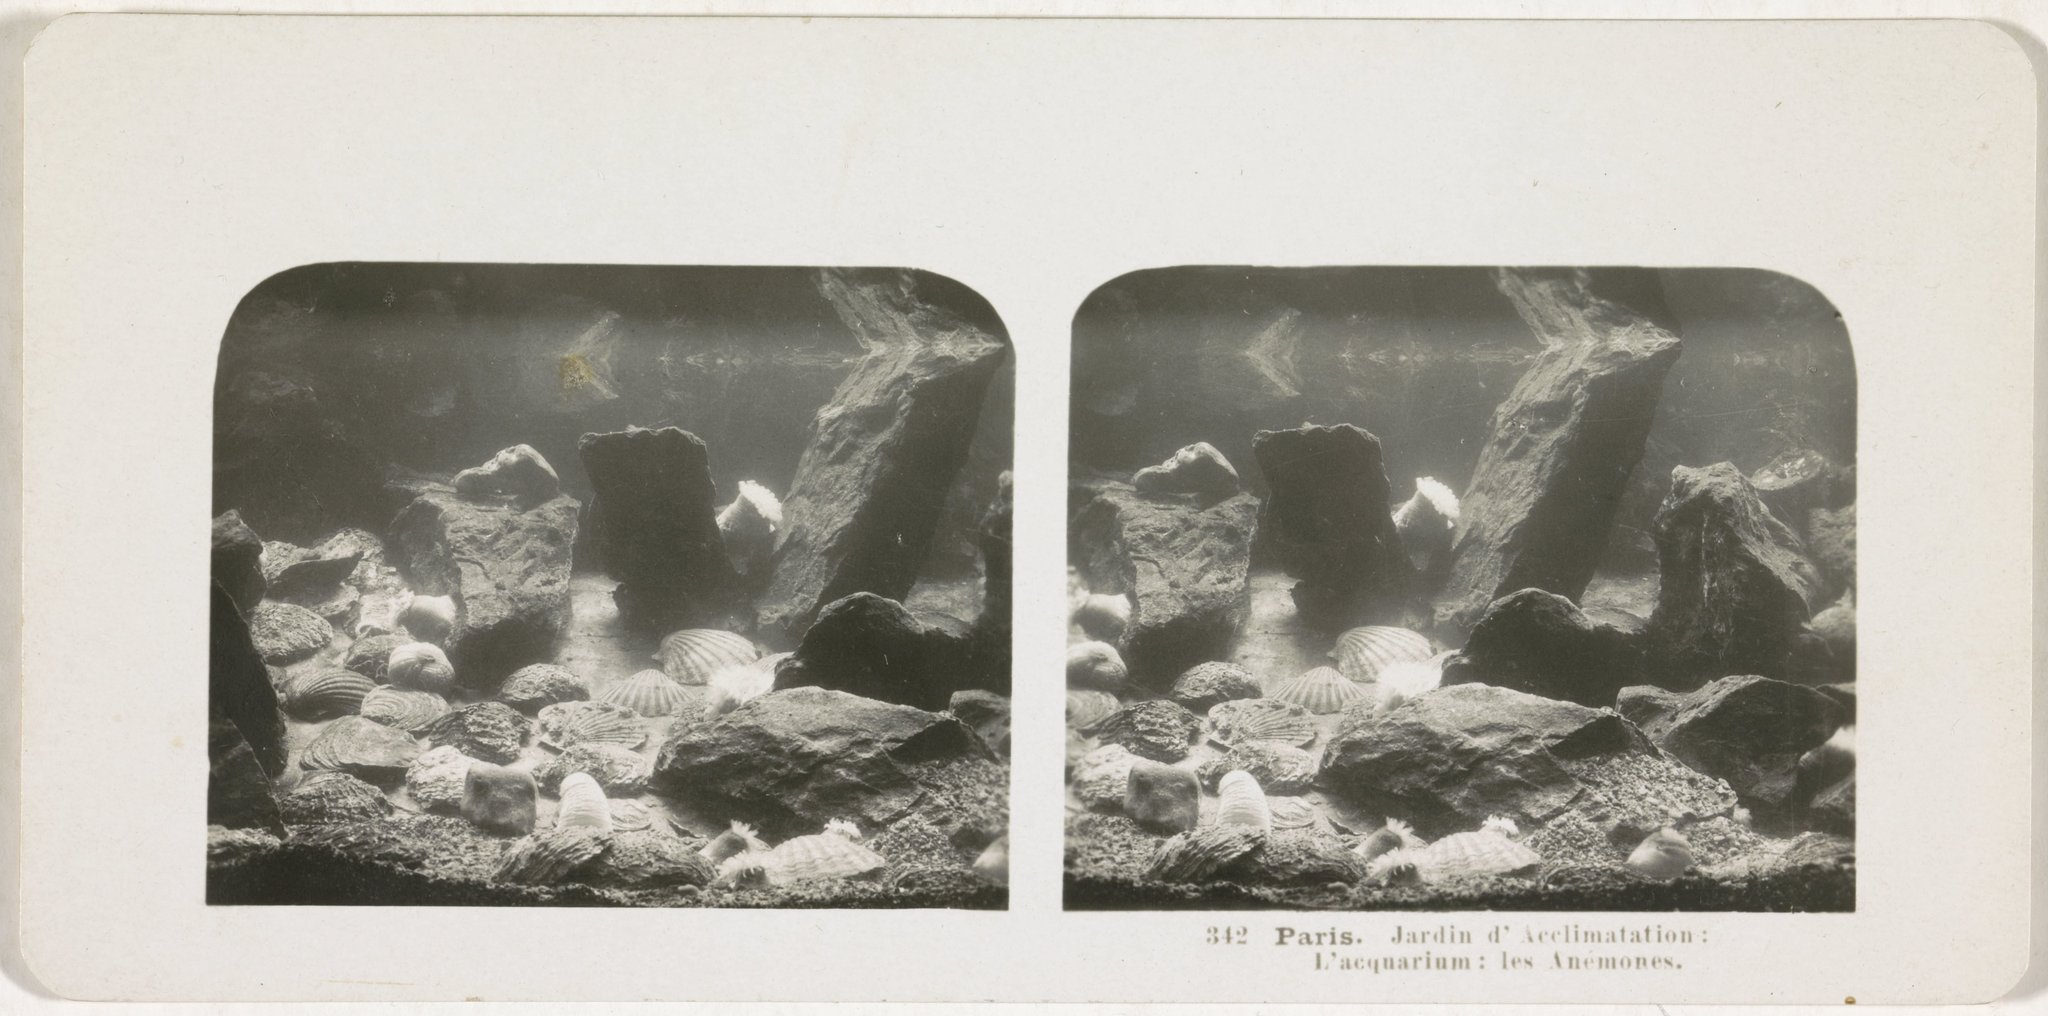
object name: stereograph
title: 342 Paris. Jardin d' Acclimatation: L'acquarium: les Anémones.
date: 1906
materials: cardboard, paper, photographic support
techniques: gelatin silver print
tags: paris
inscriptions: name: ‘Neue Photographische Gesellschaft A. G., Steglitz-Berlin 1906.’